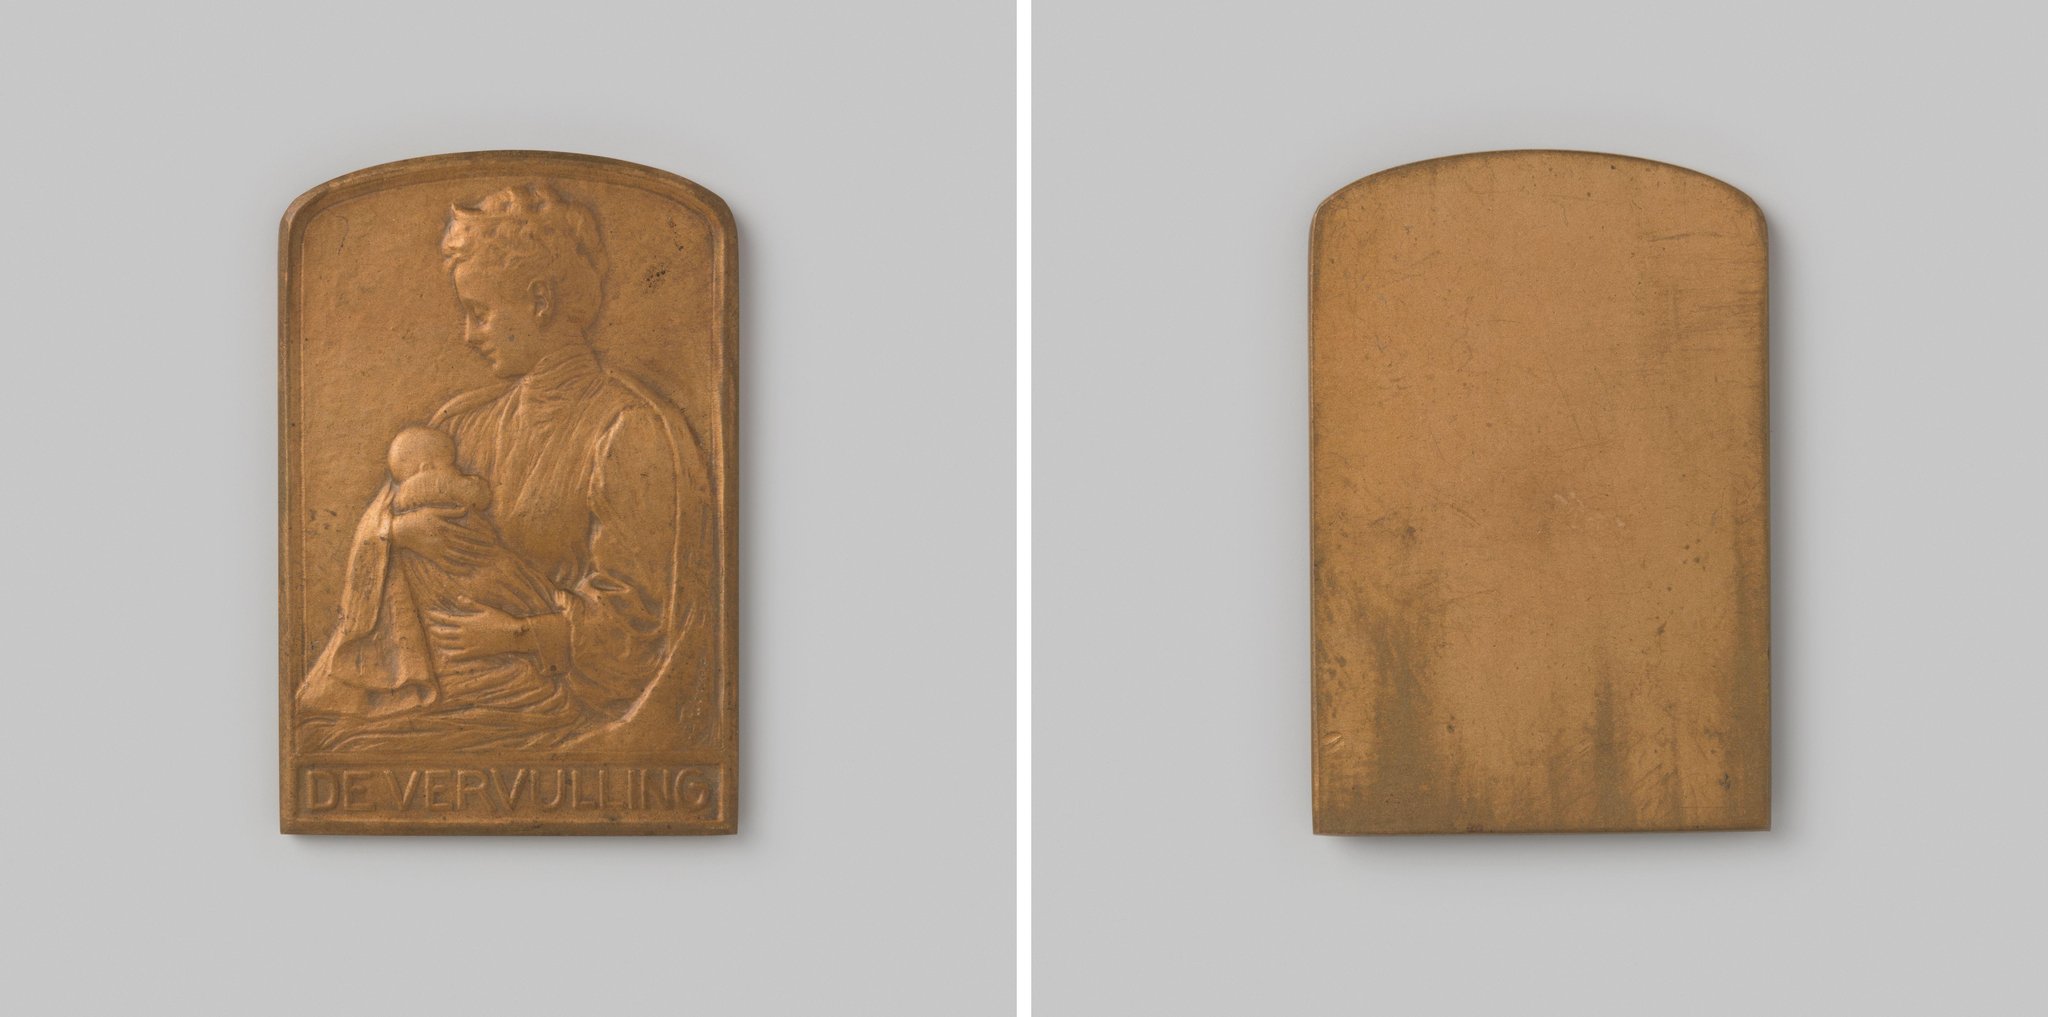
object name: history medal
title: Geboorte van prinses Juliana 1909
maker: pier pander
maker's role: designer, draughtsman, sculptor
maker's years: 1864-1919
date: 1909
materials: bronze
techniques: striking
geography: rome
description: Kleine eenzijdige bronzen plaquette waarop Koningin Wilhelmina met kind ten halven lijve boven een omkaderde tekst.